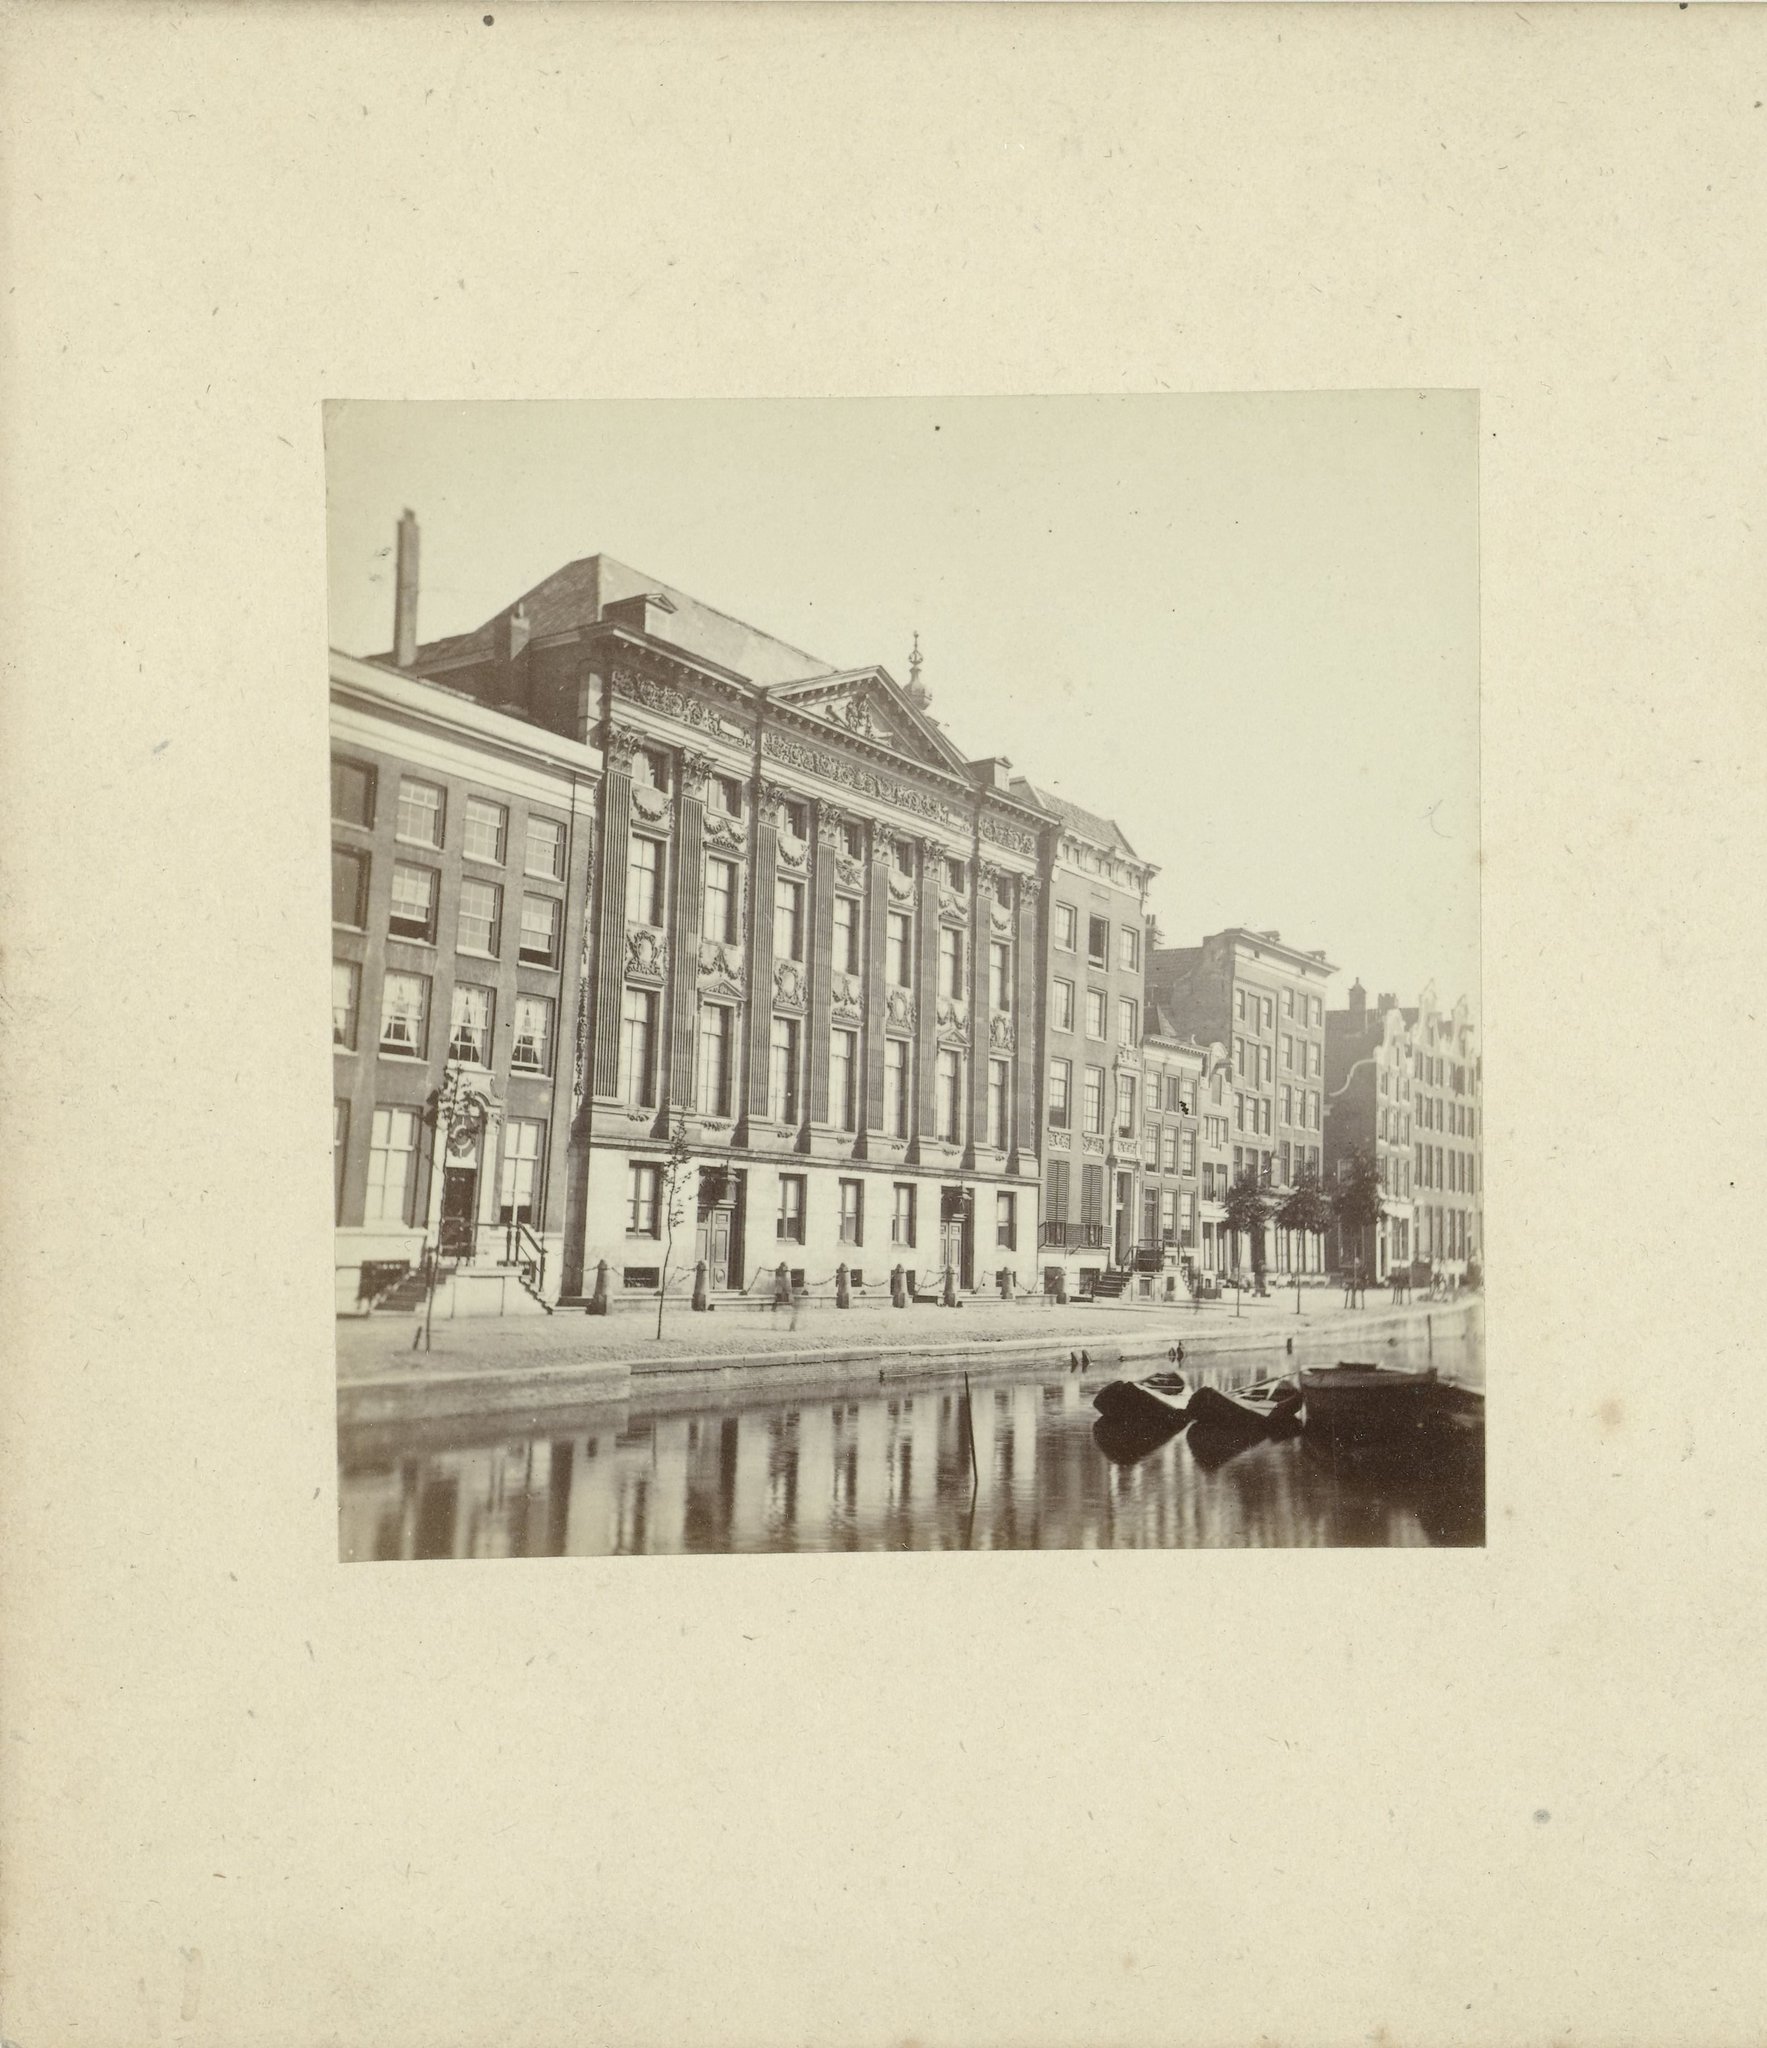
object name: photograph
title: Het Rijks Museum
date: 1860-1875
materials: cardboard, paper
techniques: albumen print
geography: amsterdam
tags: permanent exhibition, museum